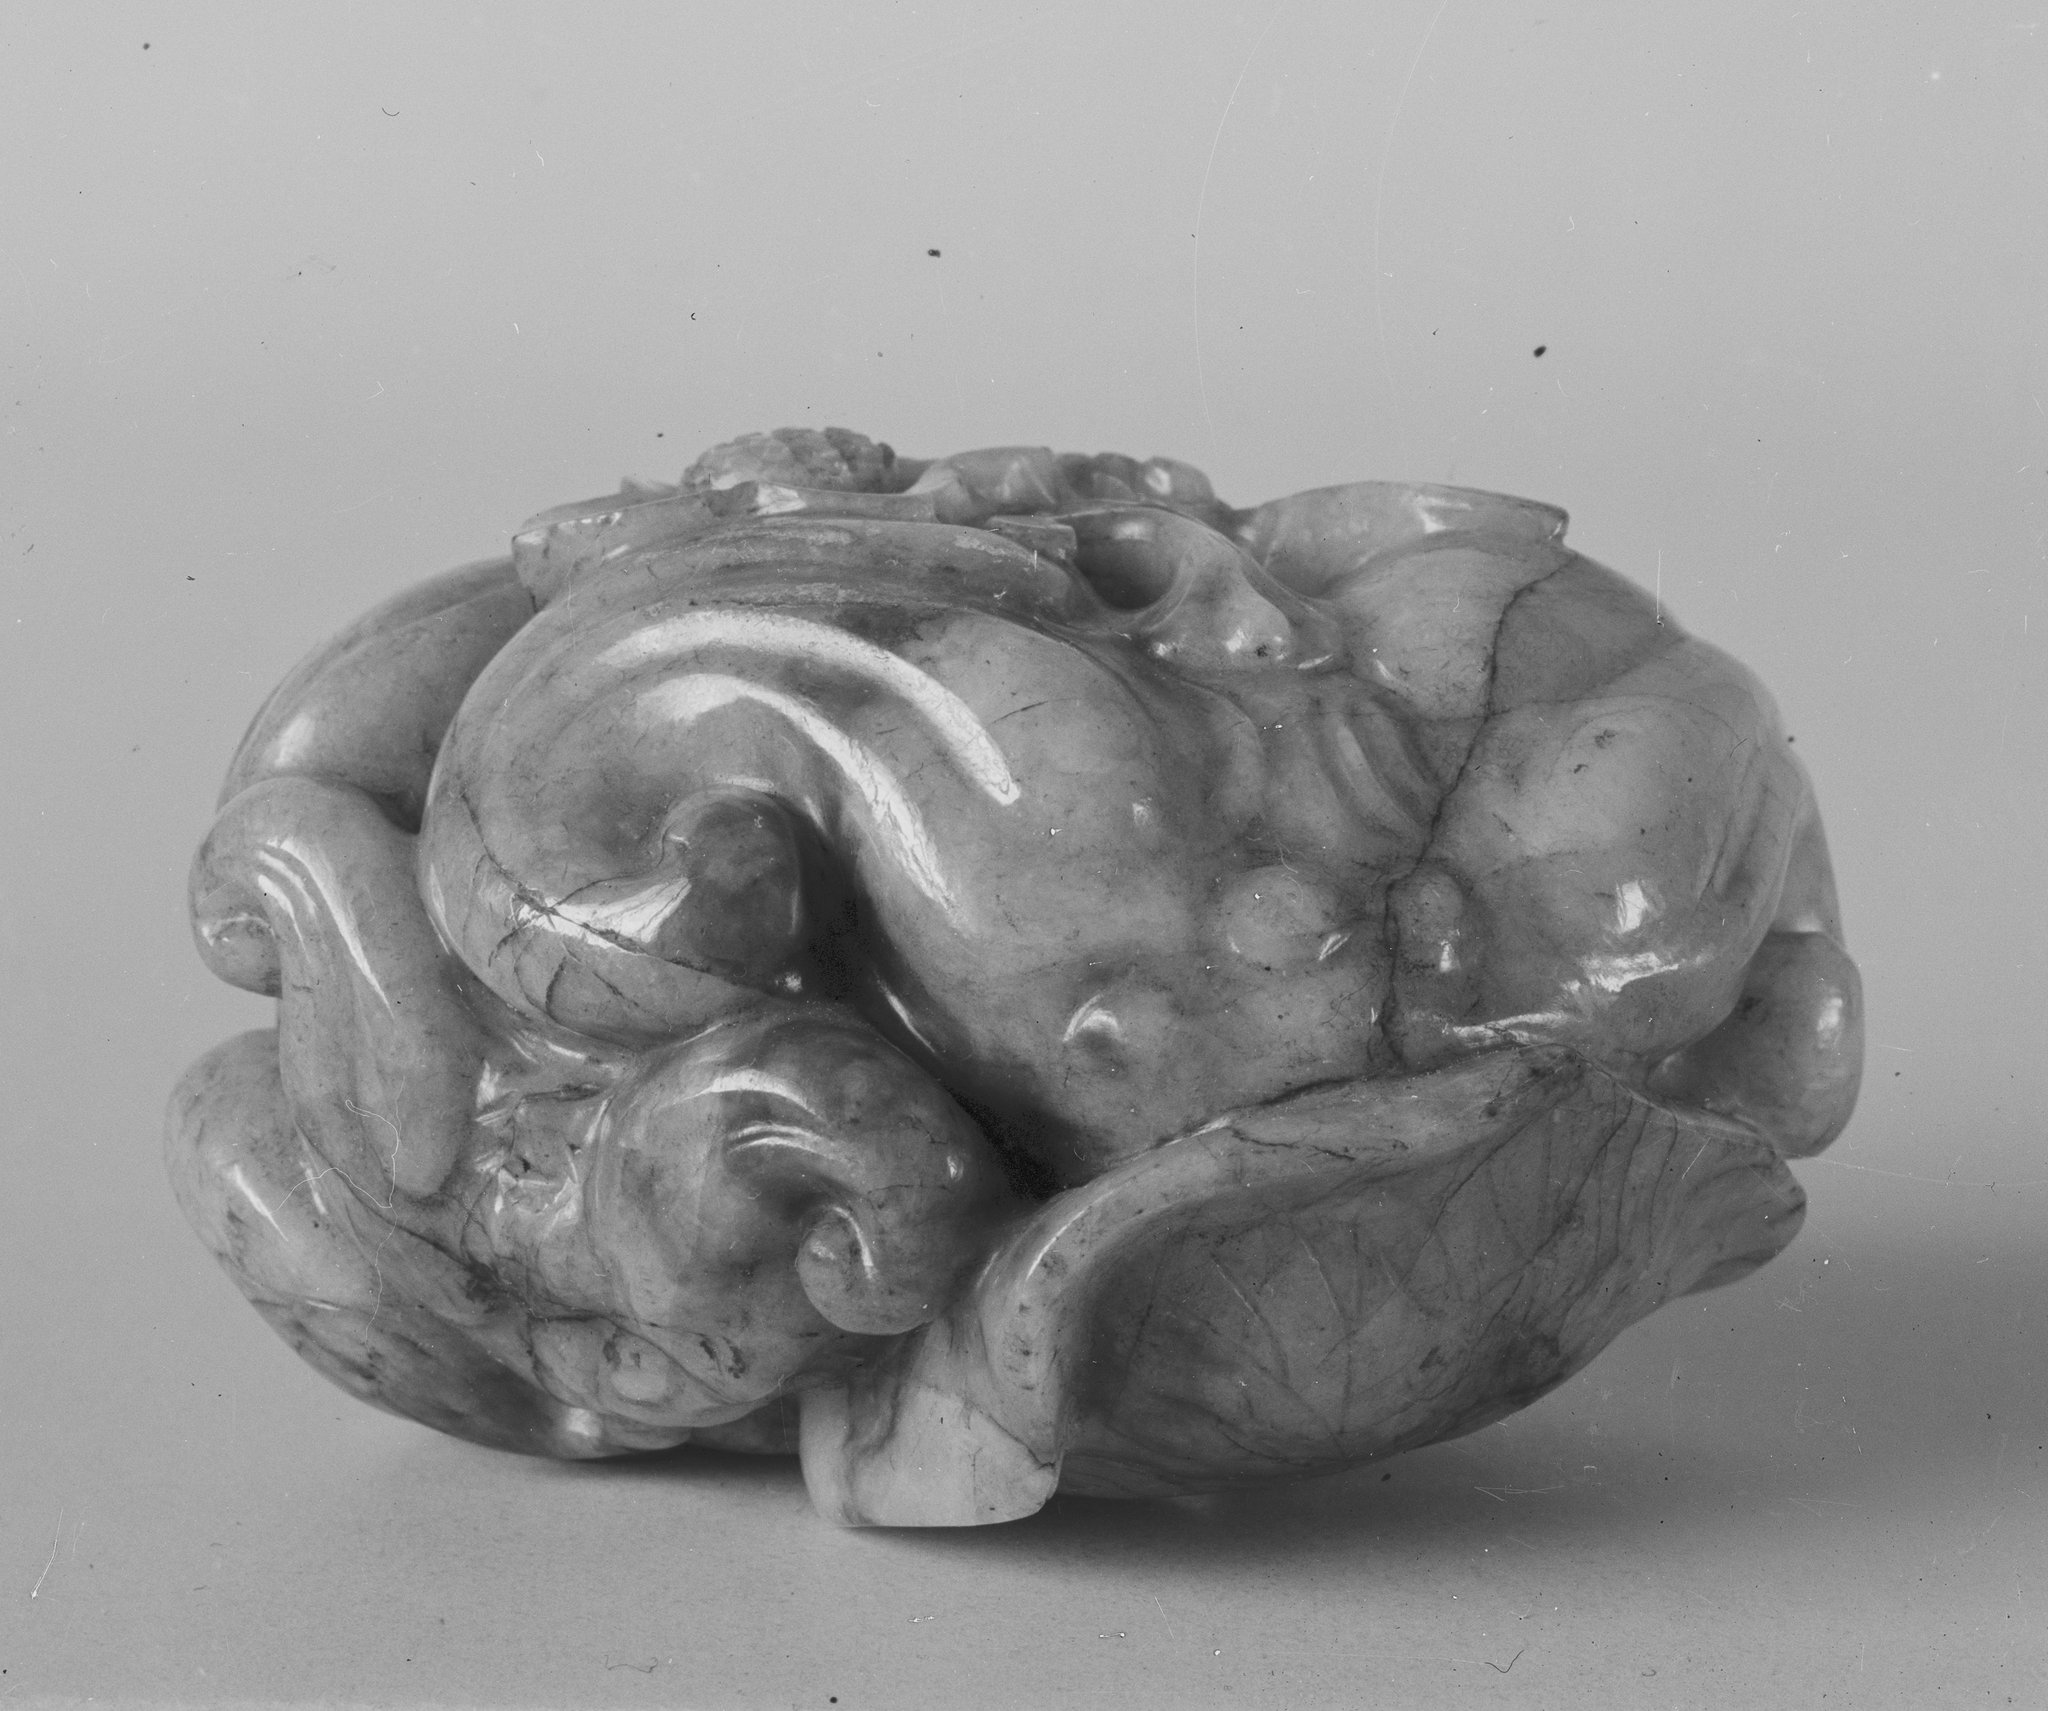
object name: ornament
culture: chinese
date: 1662-1722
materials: jade